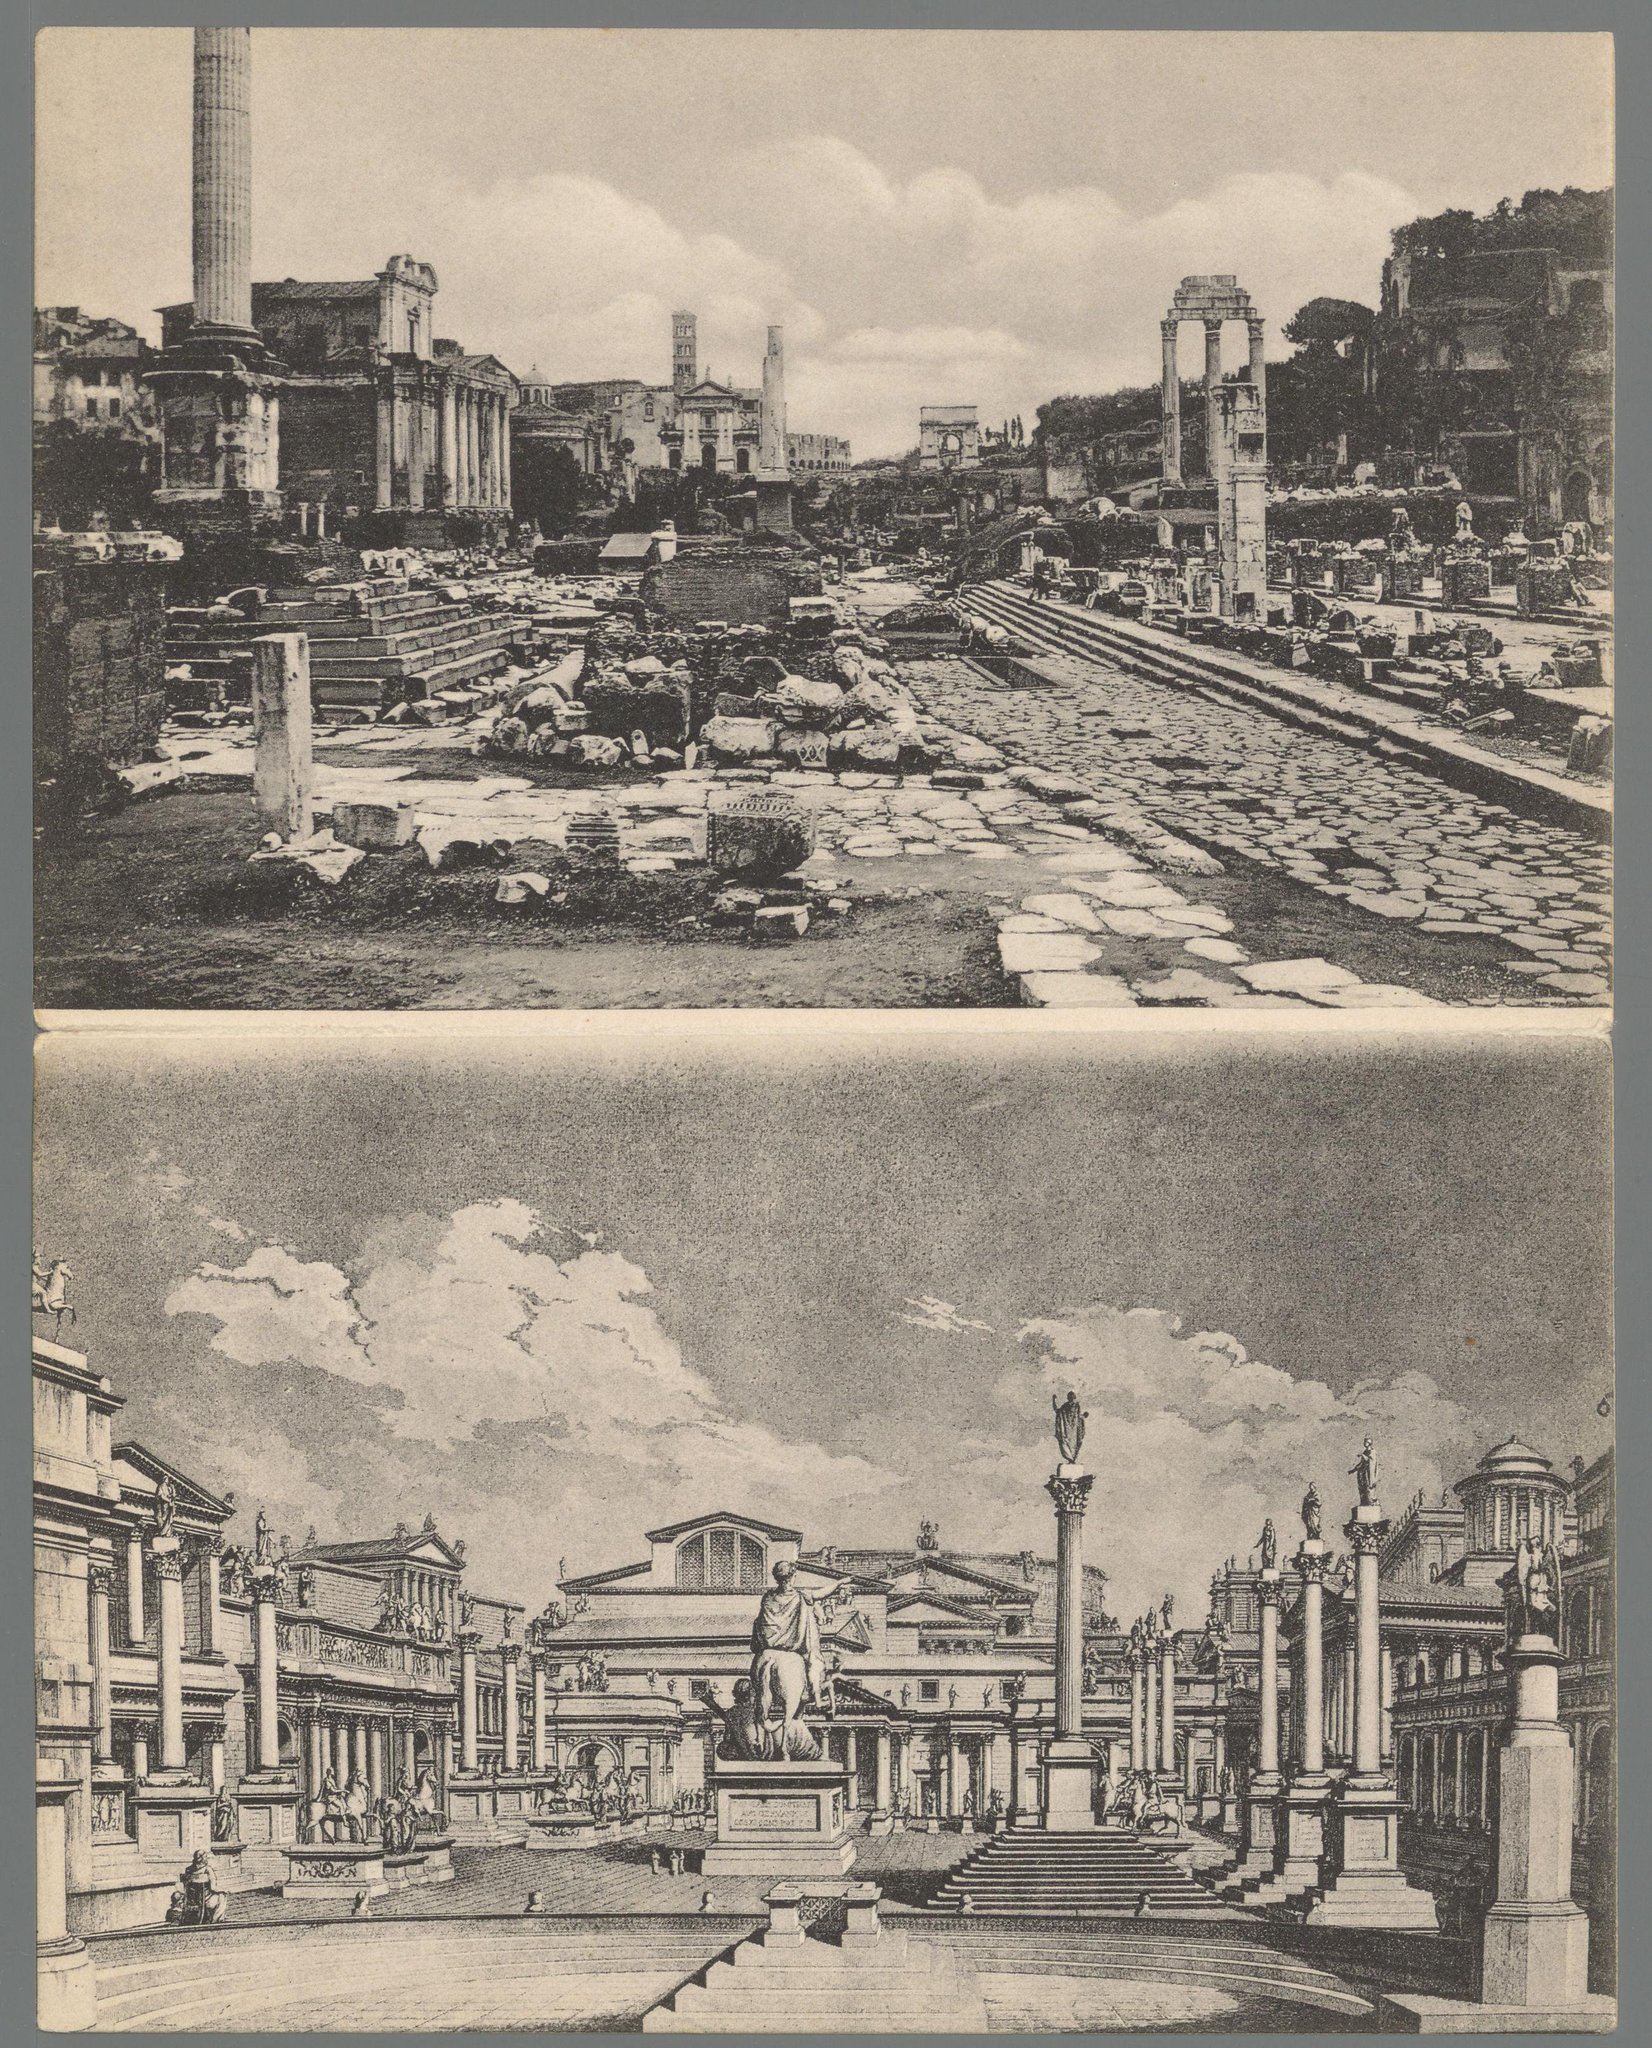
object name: ansichtkaart, prentbriefkaart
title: Forum Romain et ses monuments vus du Temple de Saturne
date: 1906-1930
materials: cardboard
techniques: photograph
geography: rome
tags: square, place, circus, etc., ruin of a building ~ architecture, temple, shrine ~ roman religion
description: De kaart is, blijkens de gedrukte tekst op verso, een voorproefje van een voorgenomen publicatie: J. Ripostelli, Rome et ses monuments à l'époque romaine, au moyen-age et de nos jours. Rome: R. Solano, z.j.